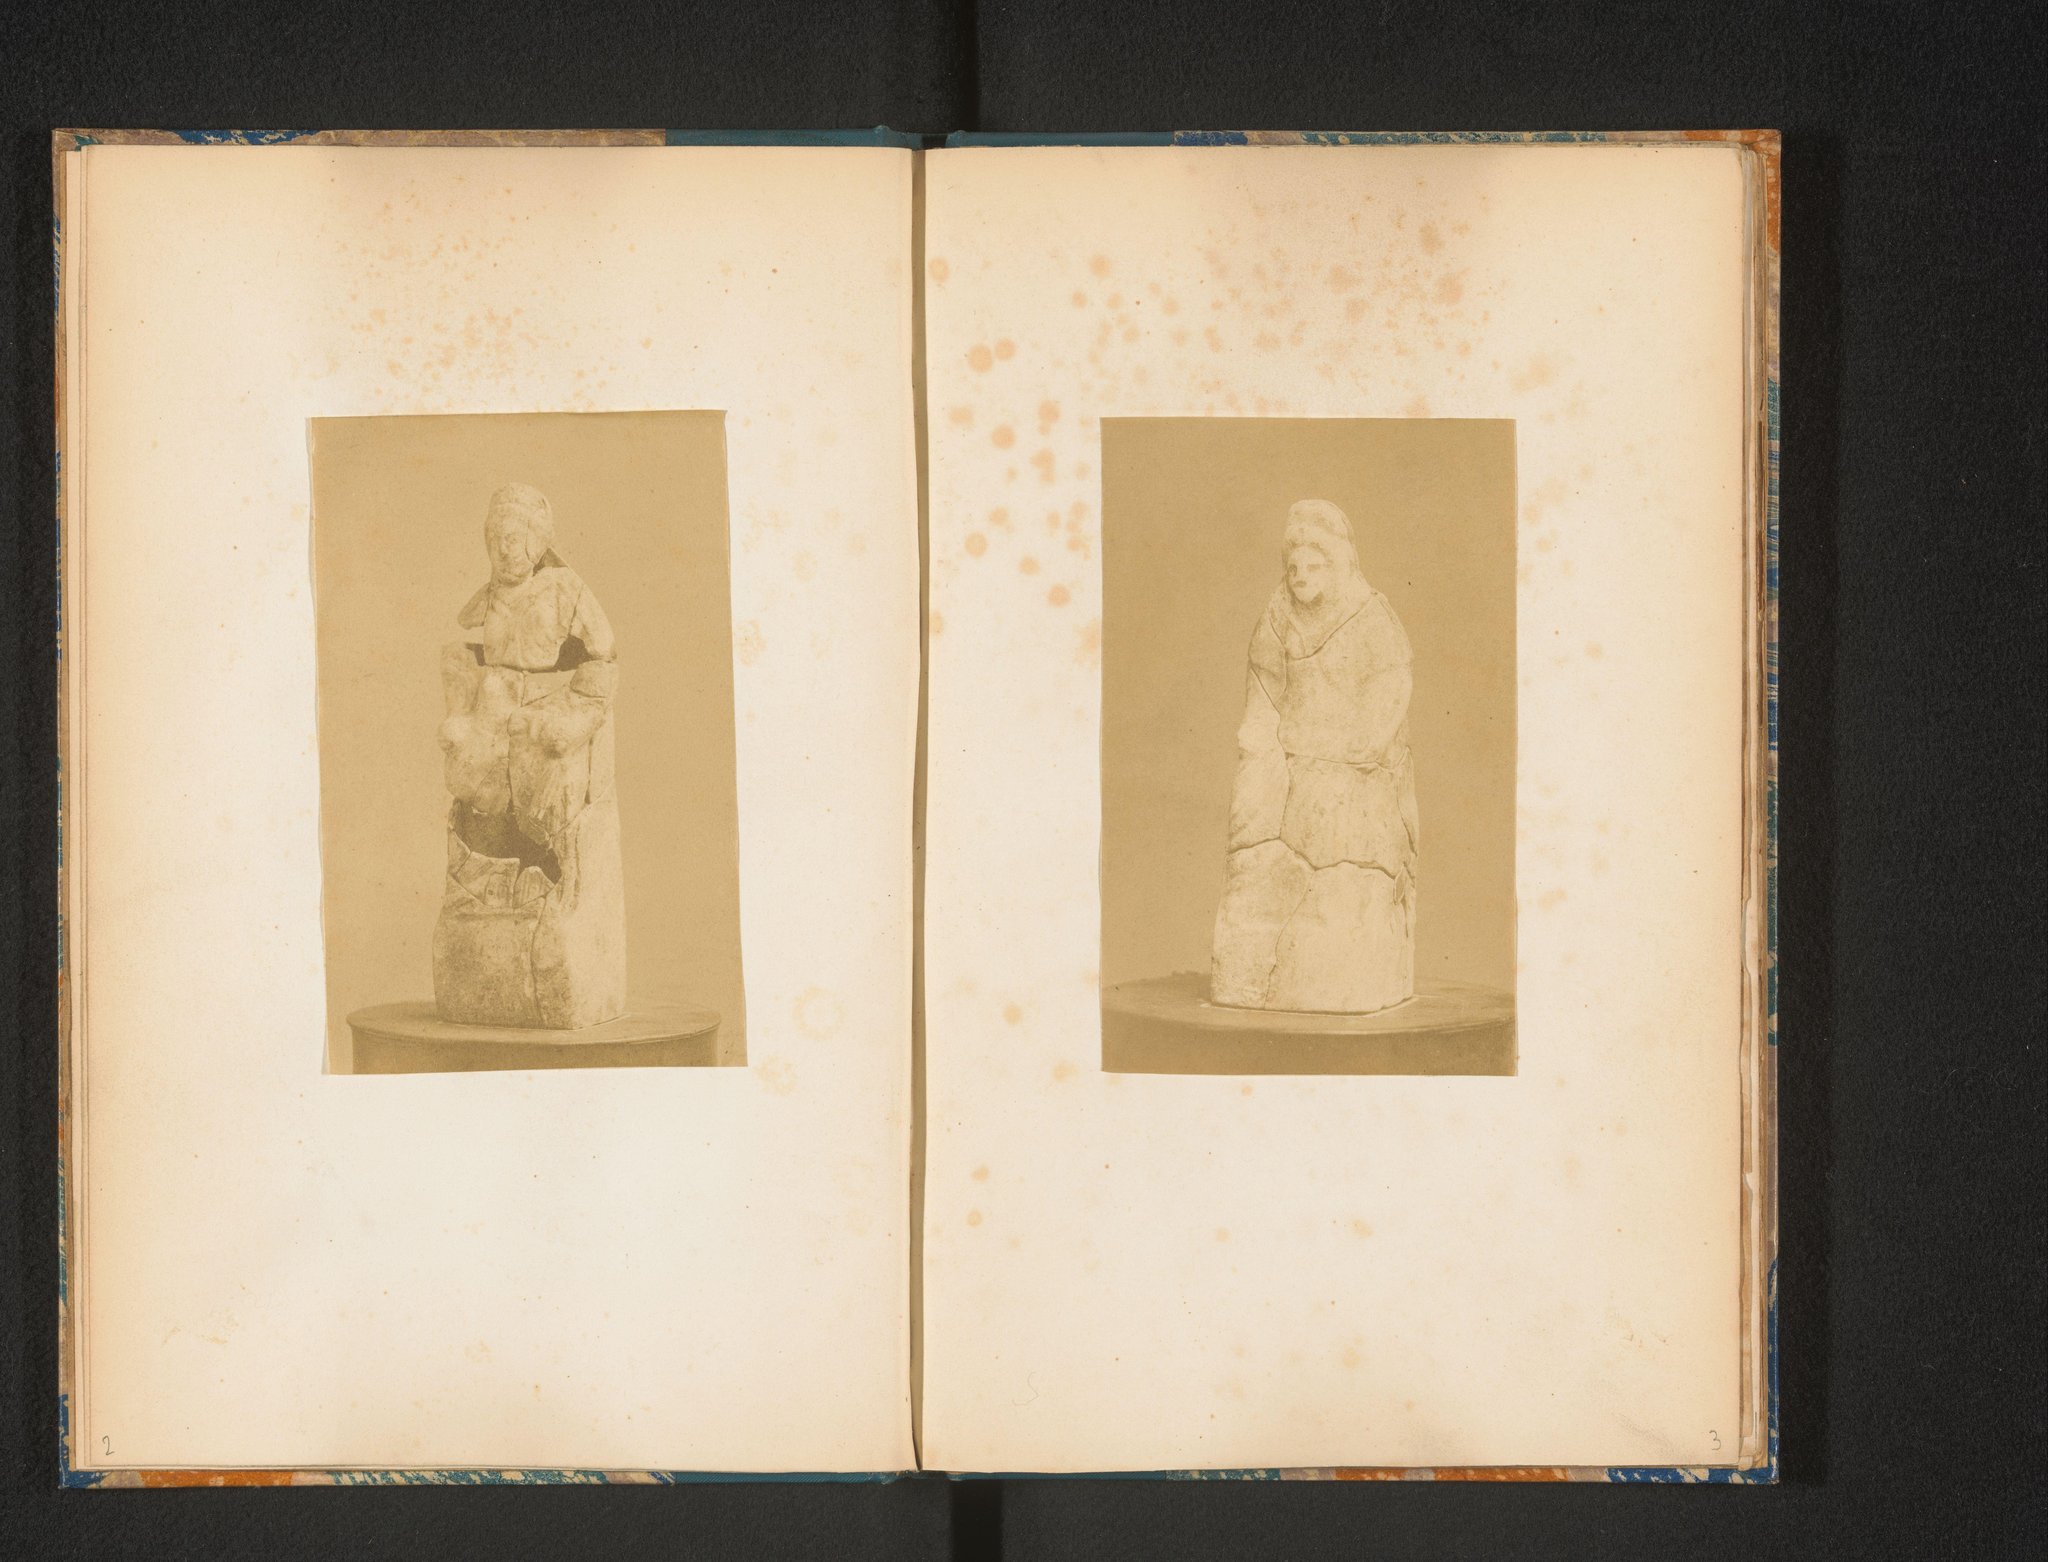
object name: photograph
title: Sculptuur, opgegraven in Juslenville in 1868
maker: Anonymous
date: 1868-1869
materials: photographic support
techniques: albumen print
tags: sculpture